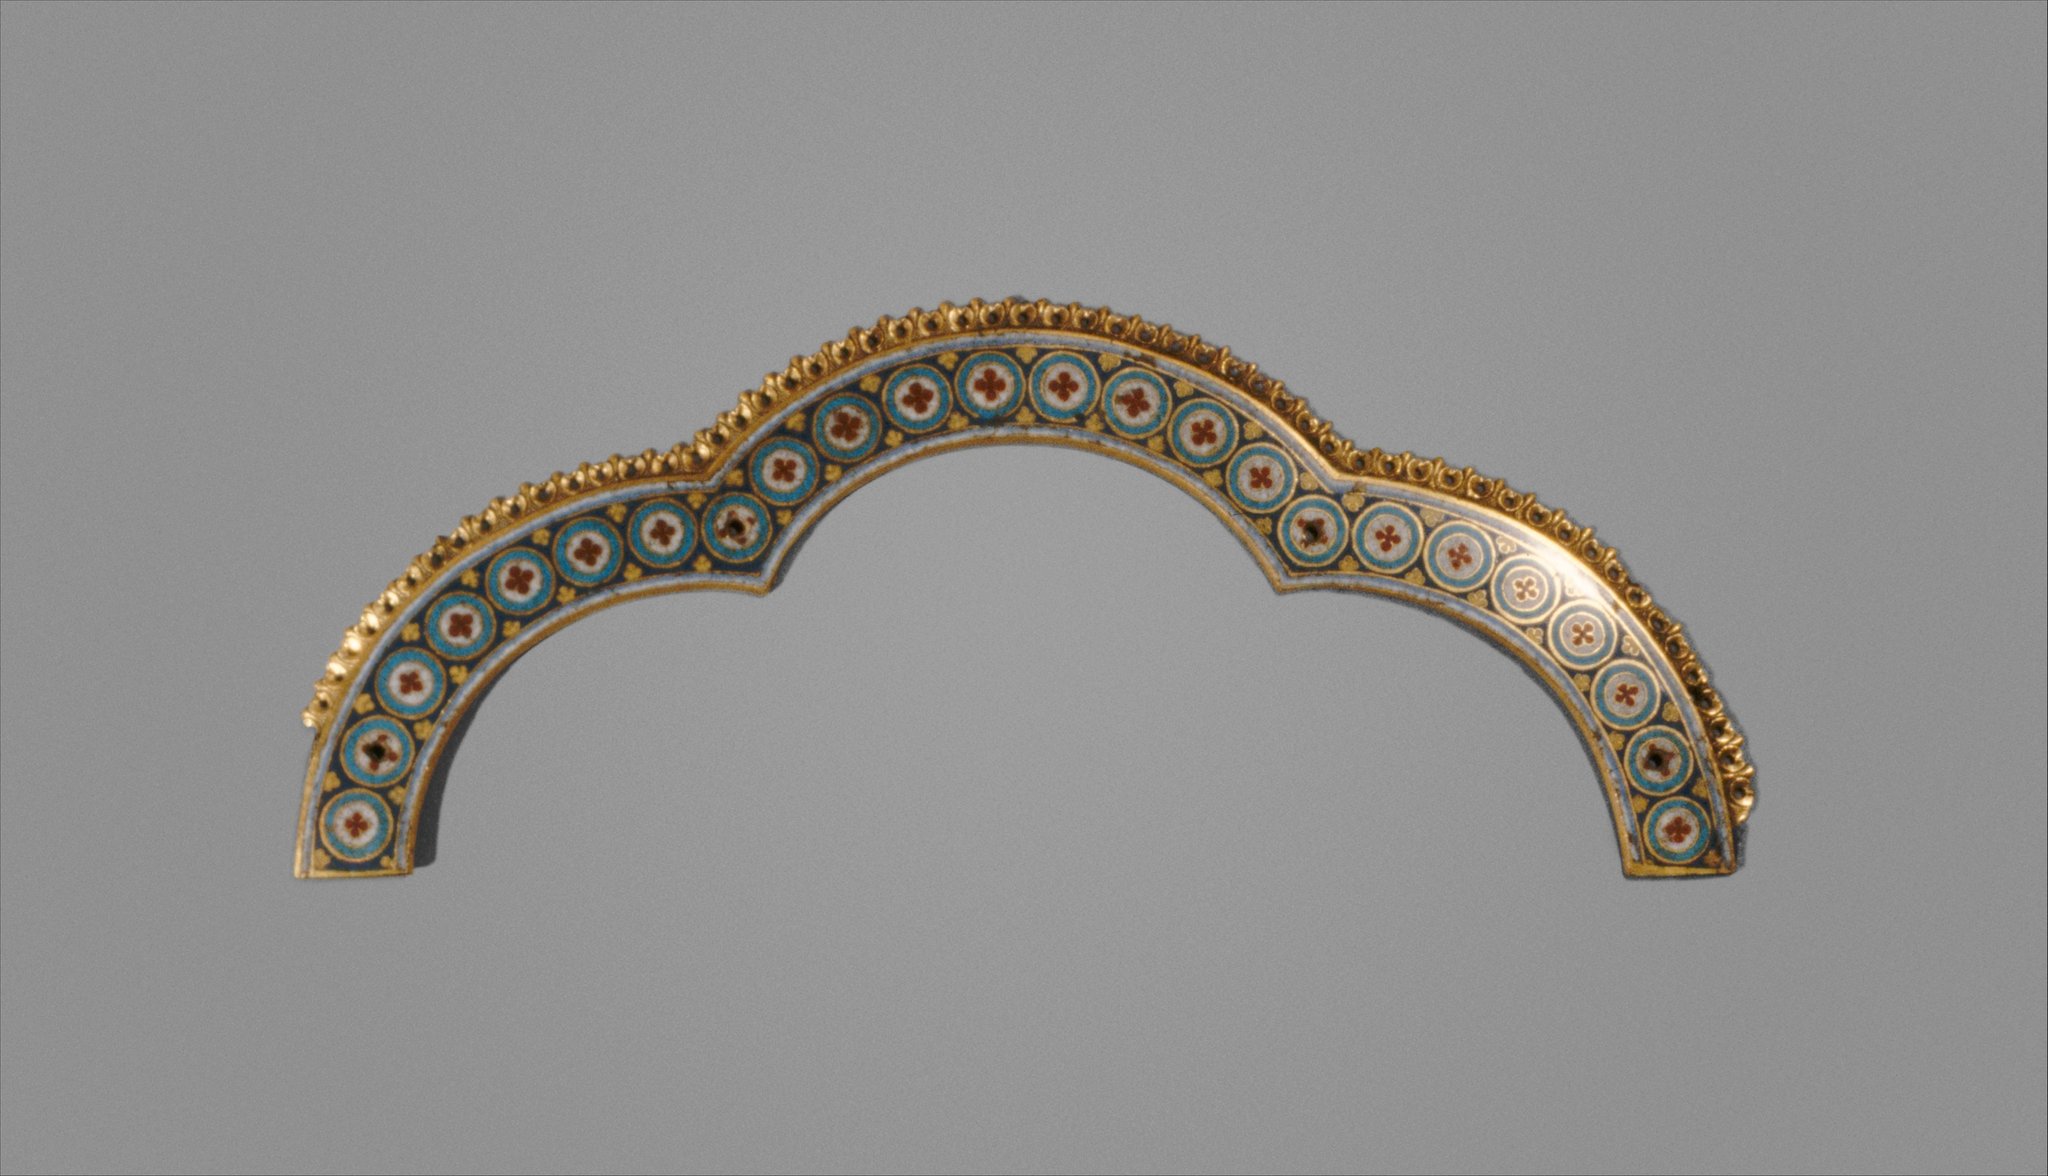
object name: arch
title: Tri-Lobed Arch from a Reliquary Shrine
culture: german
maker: nicholas of verdun and cologne followers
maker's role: artist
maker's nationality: mosan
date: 1200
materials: enamel, gilt copper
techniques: enamel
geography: germany